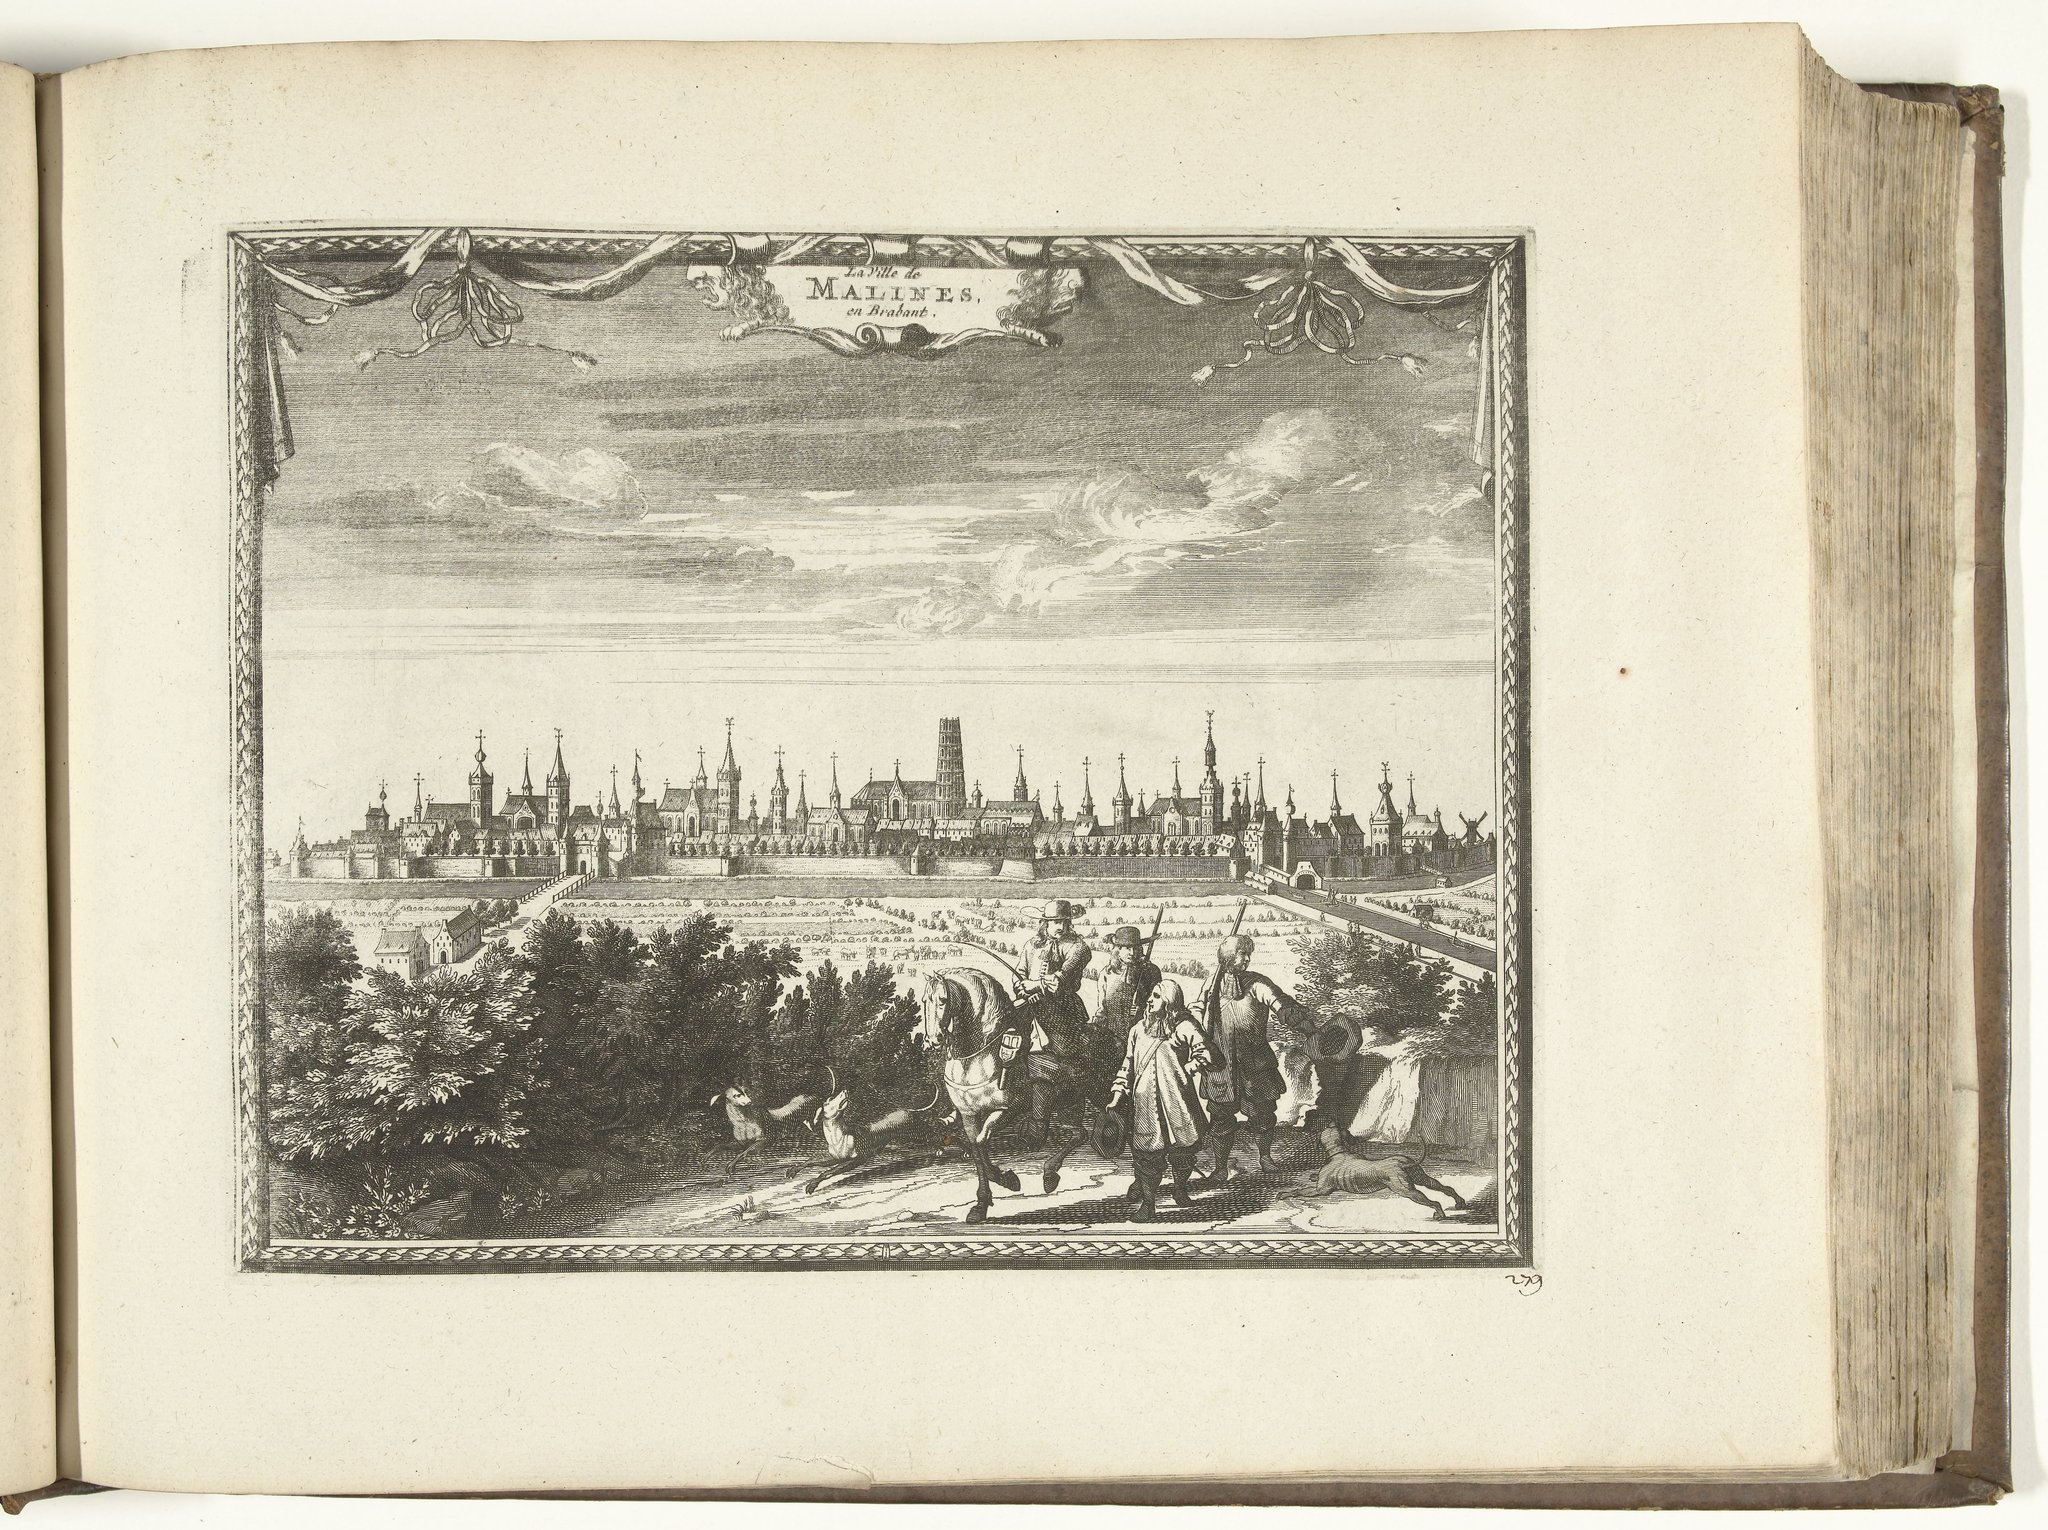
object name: print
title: Les Forces de l'Europe, Asie, Afrique et Amerique (...) Comme aussi les Cartes des Côtes de France et d'Espagne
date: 1726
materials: paper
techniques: etching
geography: northern netherlands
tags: mechelen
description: Gezicht op Mechelen, op de voorgrond een groepje jagers. Plaat nr. 279 in deel XII van het prentwerk: Les Forces de l'Europe, Asie, Afrique et Amerique ... Comme aussi les Cartes des Côtes de France et d'Espagne uit 1726, dit tweede deel met 271 met de hand genummerde platen van vermaarde sterke steden en vestingen in het kader van de Spaanse Successieoorlog 1701-1713. Voor het merendeel zijn deze platen gekopieerd naar de anonieme Franse platen van vermaarde sterke steden en vestingen: in Les forces de l'Europe en in: Le theatre de la guerre, dans les Pays-Bas, beide oorspronkelijk uitgegeven door Nicolas de Fer te Parijs (1693-1697) in het kader van de Negenjarige Oorlog. Titel in het Frans.